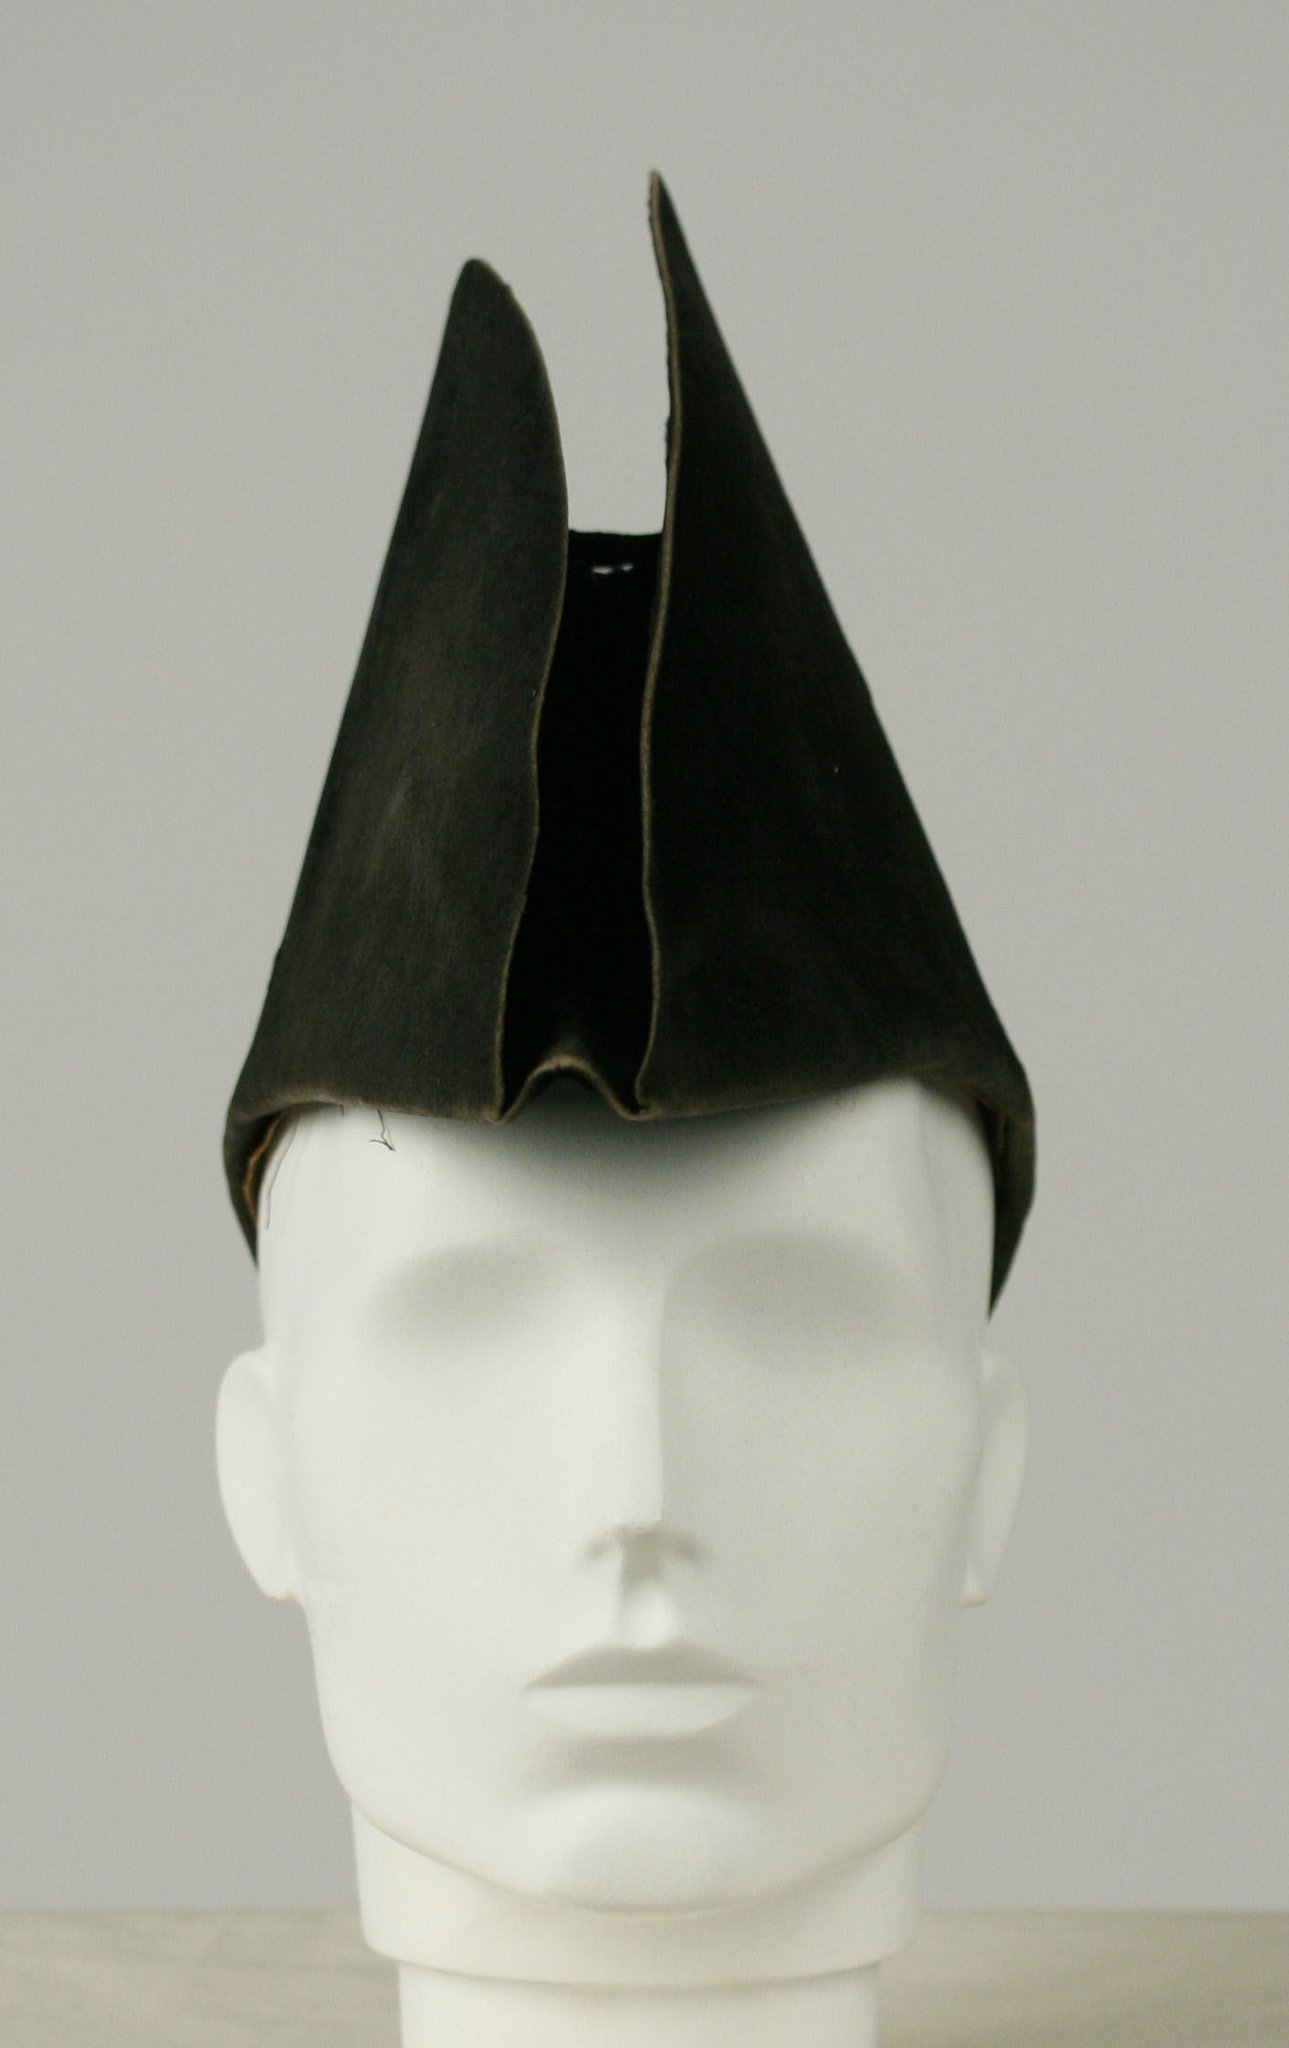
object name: bicorne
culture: french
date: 1750-1775